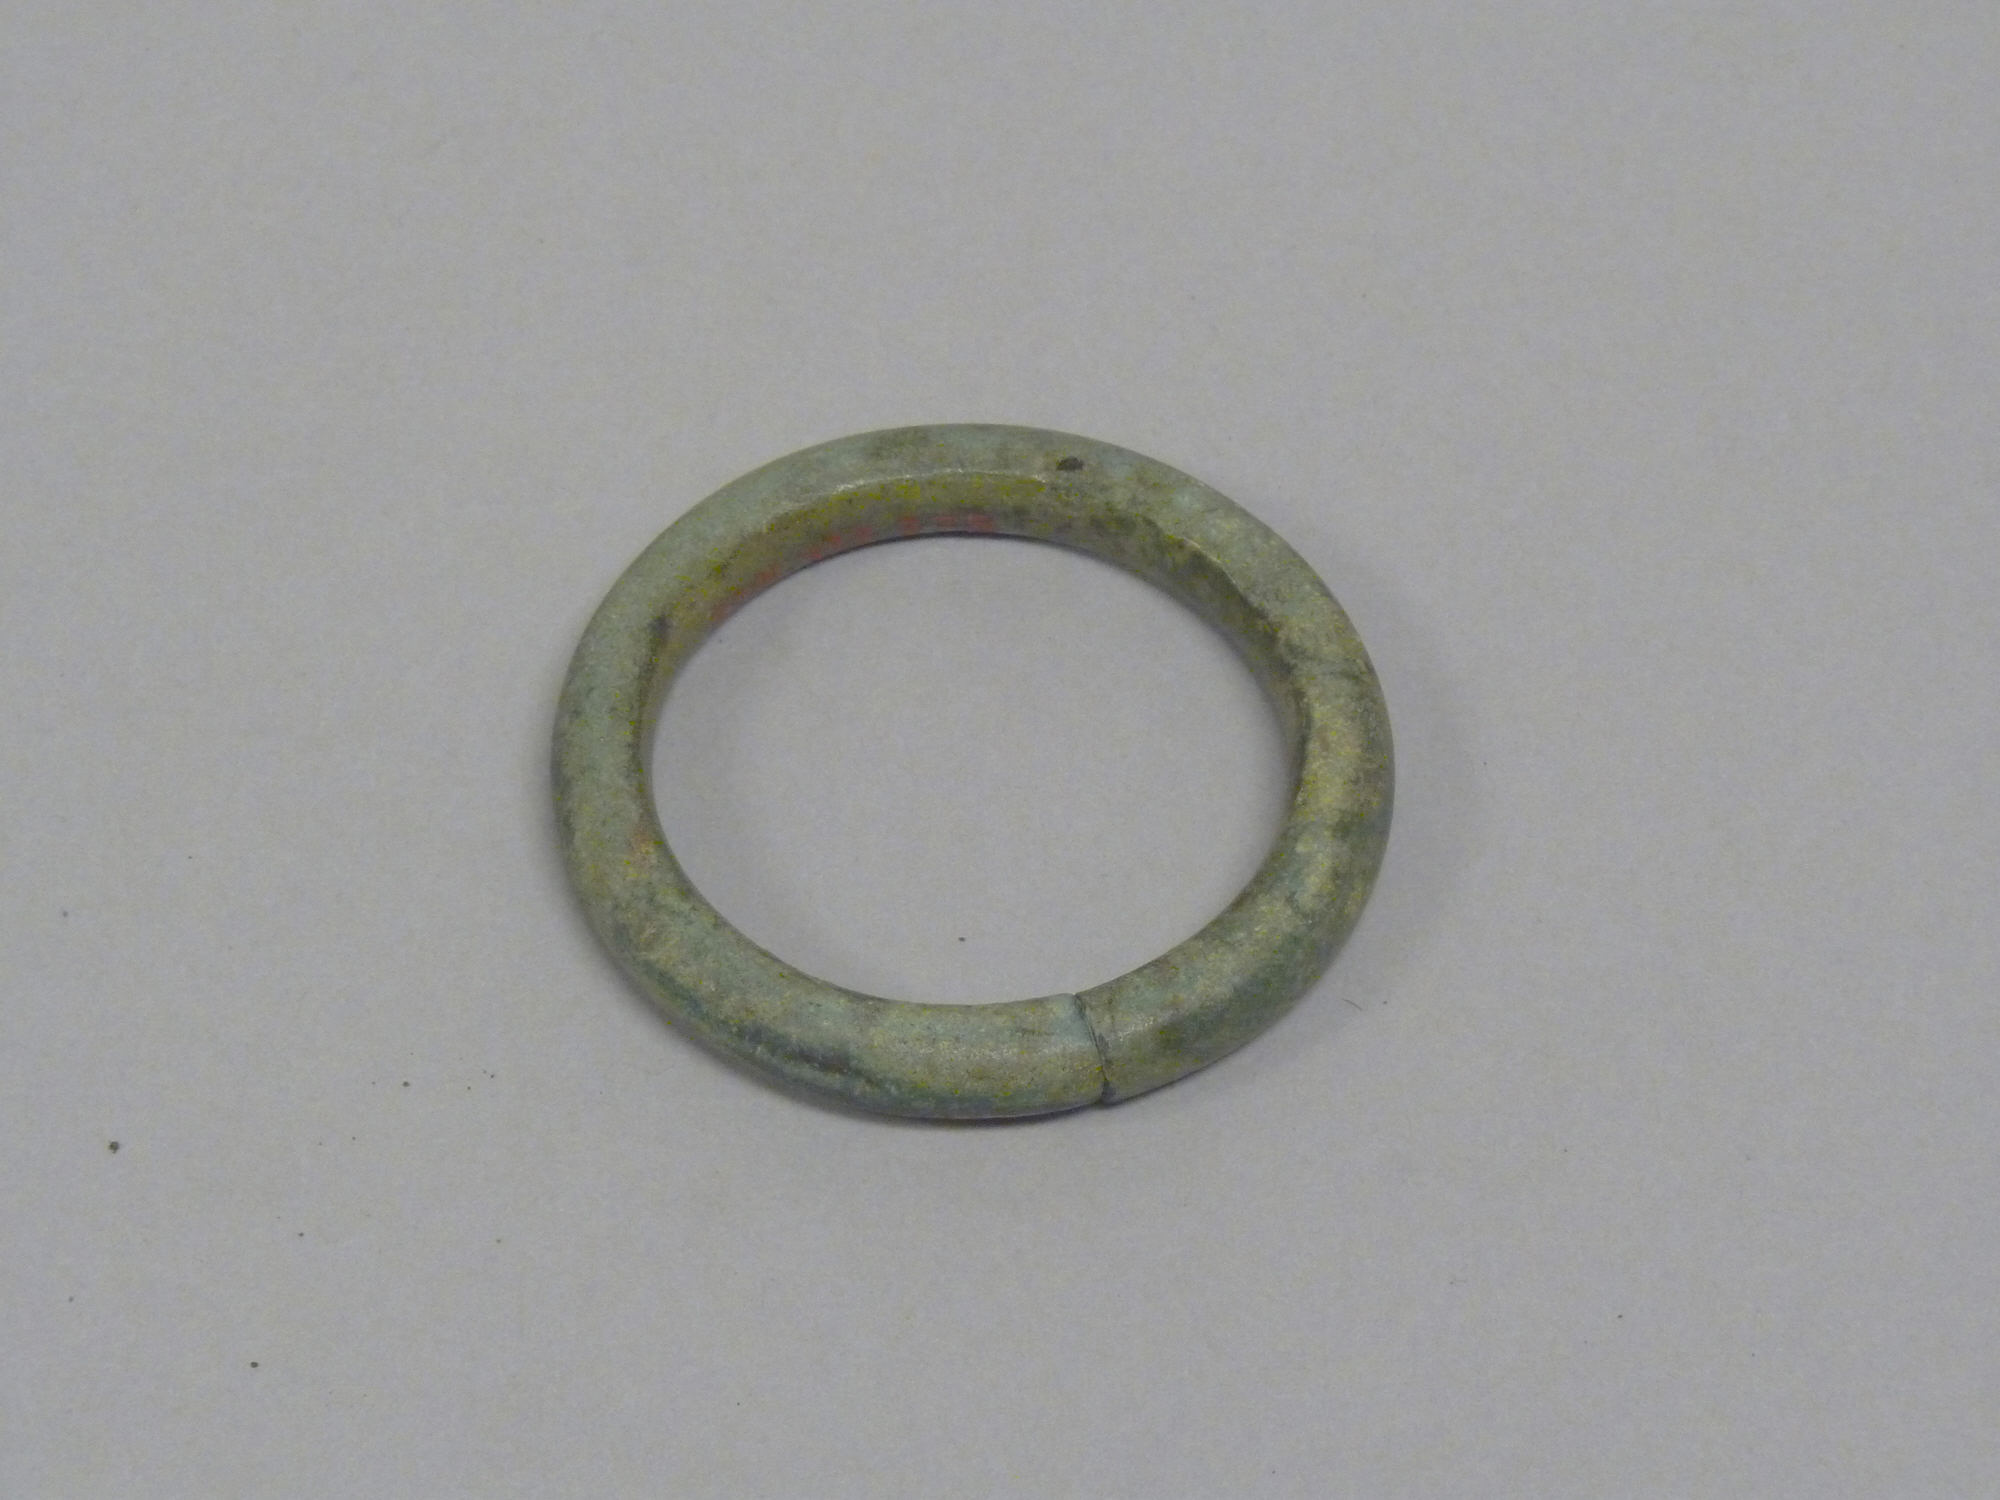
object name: solid undecorated bangle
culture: thai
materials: bronze